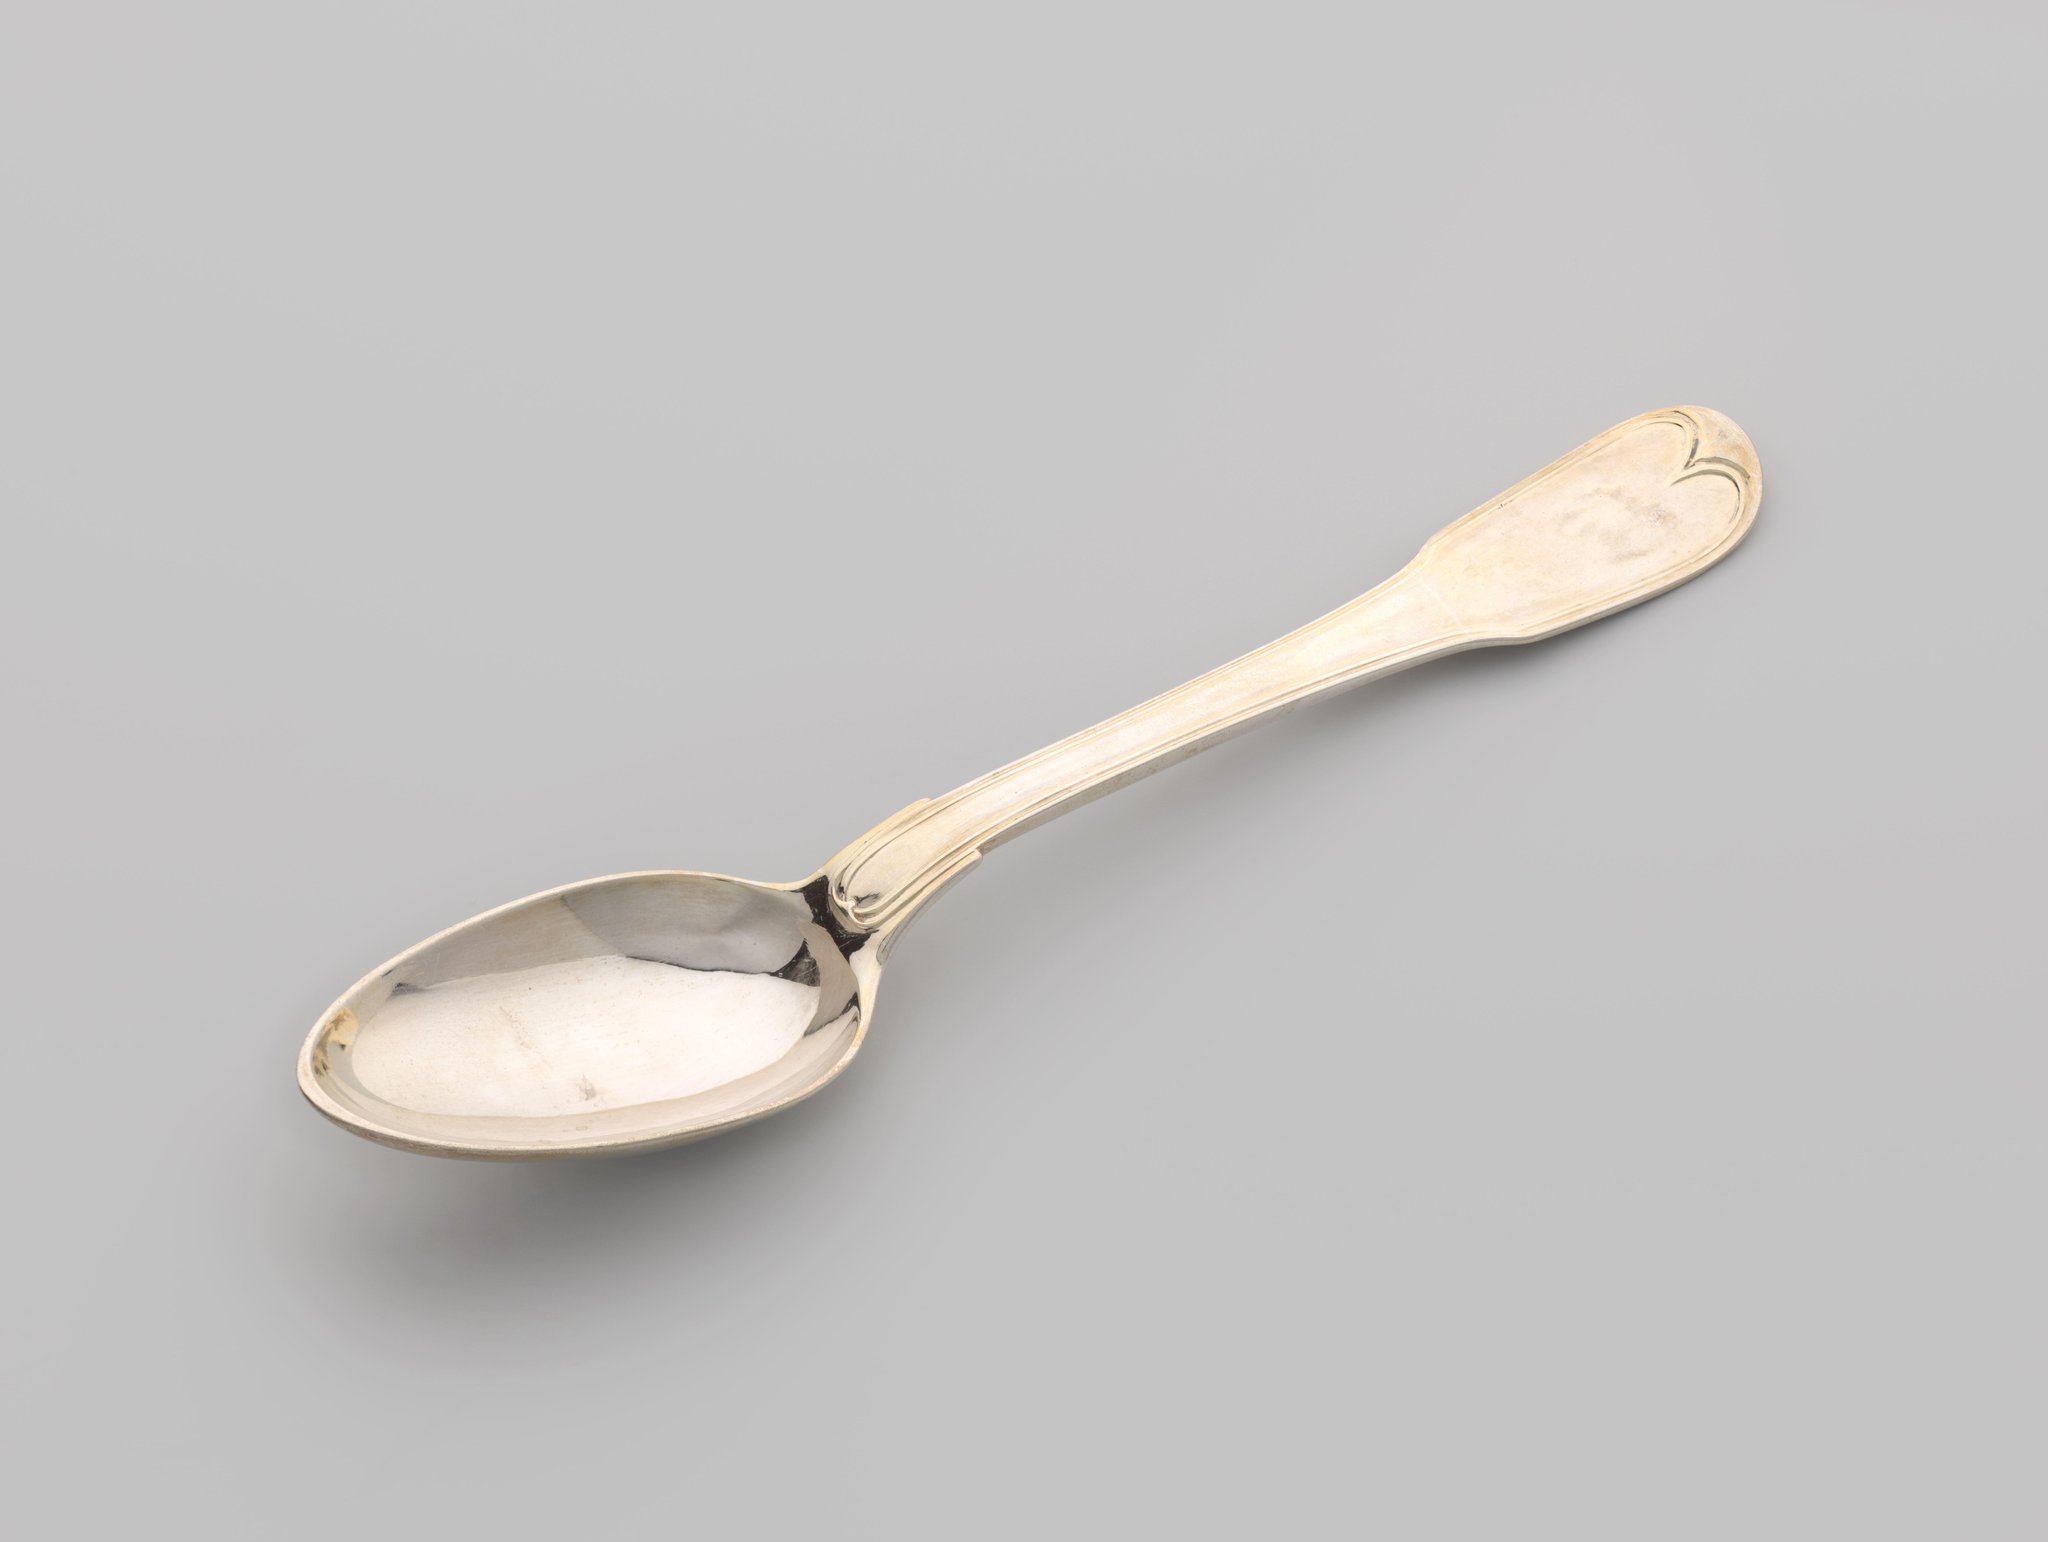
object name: dessert spoon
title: Dessertlepel met het helmteken Clifford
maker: roelof helweg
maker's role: silversmith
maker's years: 1758-1843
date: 1806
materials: silver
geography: amsterdam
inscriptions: alloy mark: ‘Hollandse leeuw’, town mark: ‘Amsterdam’, date letter: ‘X (=1806)’, maker's mark: ‘RH in ovaal’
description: De eivormige bak van de lepel heeft een versmald uiteinde en is aan zowel boven- als onderzijde door middel van enkel lof verbonden met de platte, gebogen steel, die zich verbreedt naar het spatelvormige uiteinde. Boven- en onderzijde van de steel worden omgeven door een dubbele filetrand, die bij het uiteinde ingezwenkt is. Op de onderzijde van de spatel van zowel de lepels als de vorken is het helmteken Clifford gegraveerd.